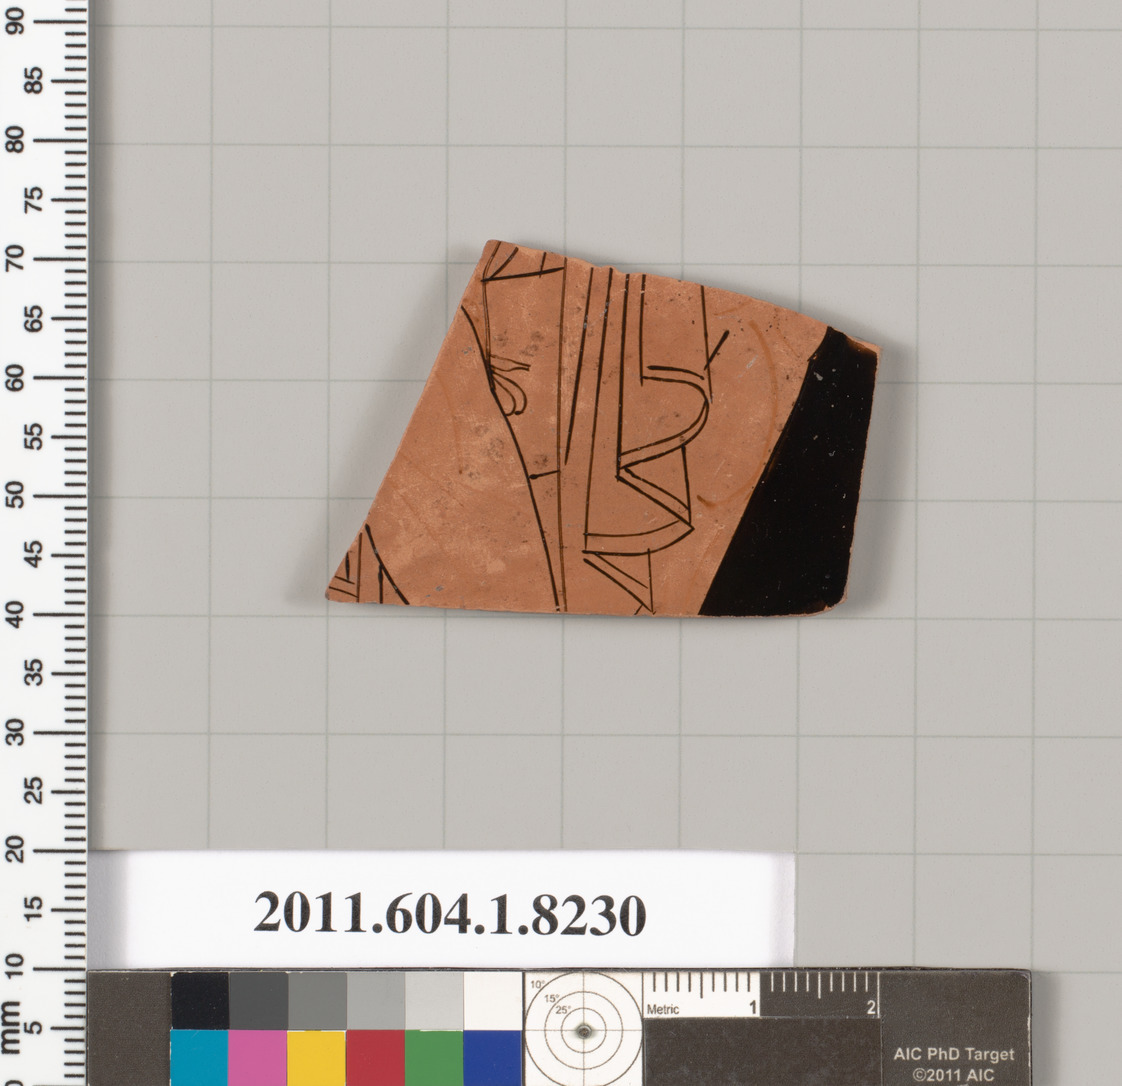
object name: kylix fragment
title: Terracotta fragment of a kylix (drinking cup)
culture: greek, attic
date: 520-510 BCE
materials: terracotta